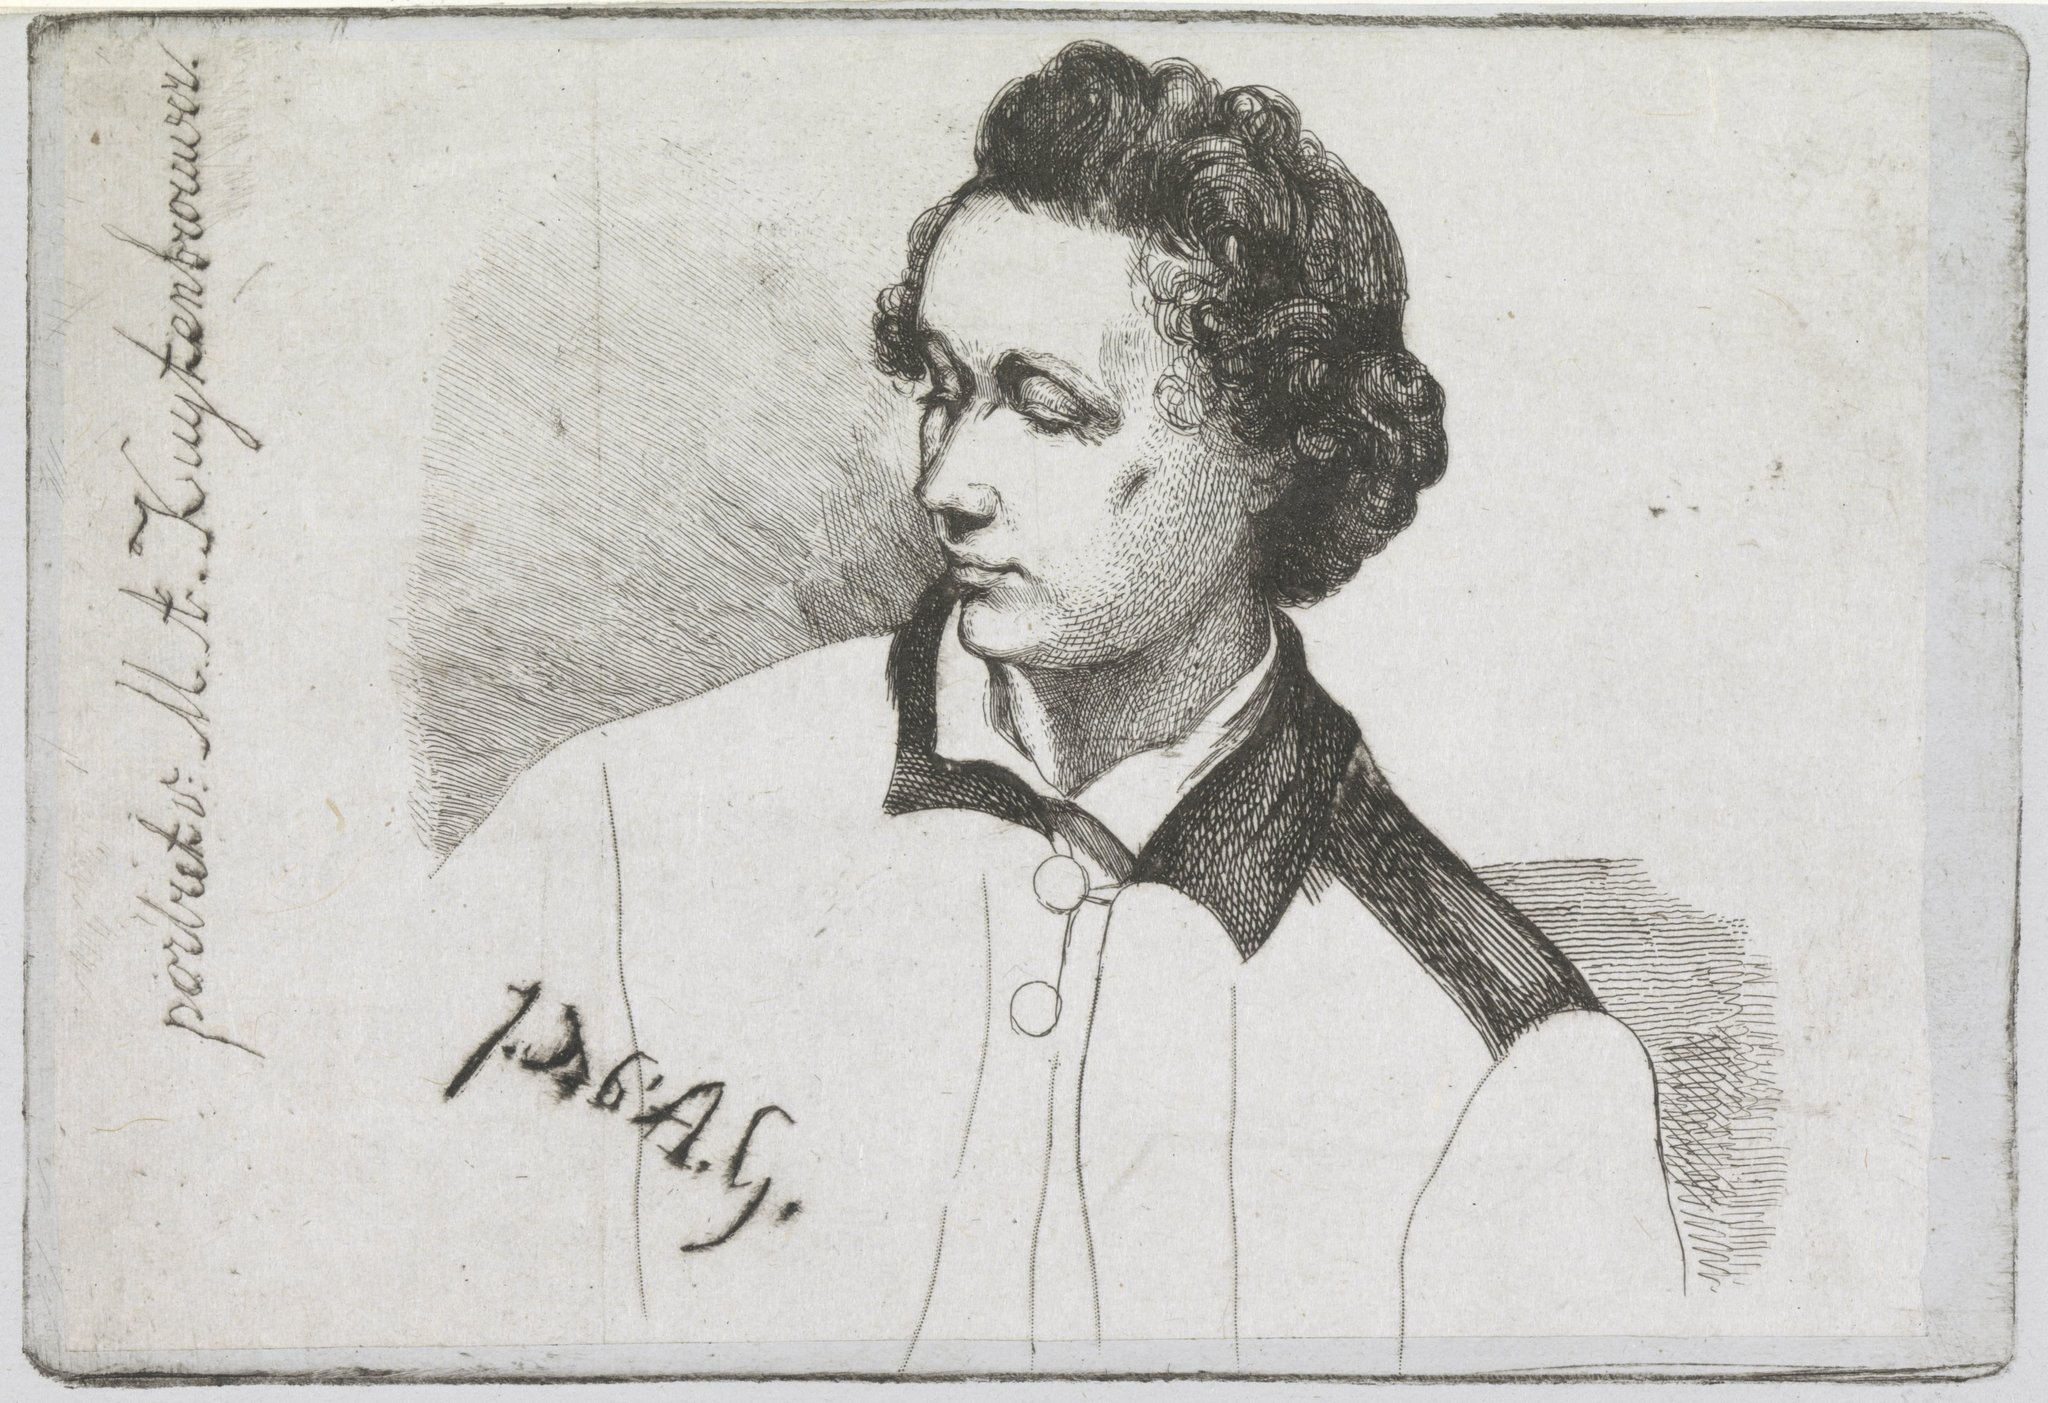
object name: print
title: Portret v. M.A. Kuytenbrouwer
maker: johannes christiaan d arnaud gerkens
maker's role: draughtsman, print maker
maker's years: 1823-1892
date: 1833-1891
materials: paper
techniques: etching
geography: the hague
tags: paris, painter, print maker, draughtsman, martinus antonius kuytenbrouwer jr.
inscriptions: collector's mark: Lugt 2228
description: Portret van Martinus Antonius Kuytenbrouwer, een schilder aan het hof van Napoleon III. Buste naar links.